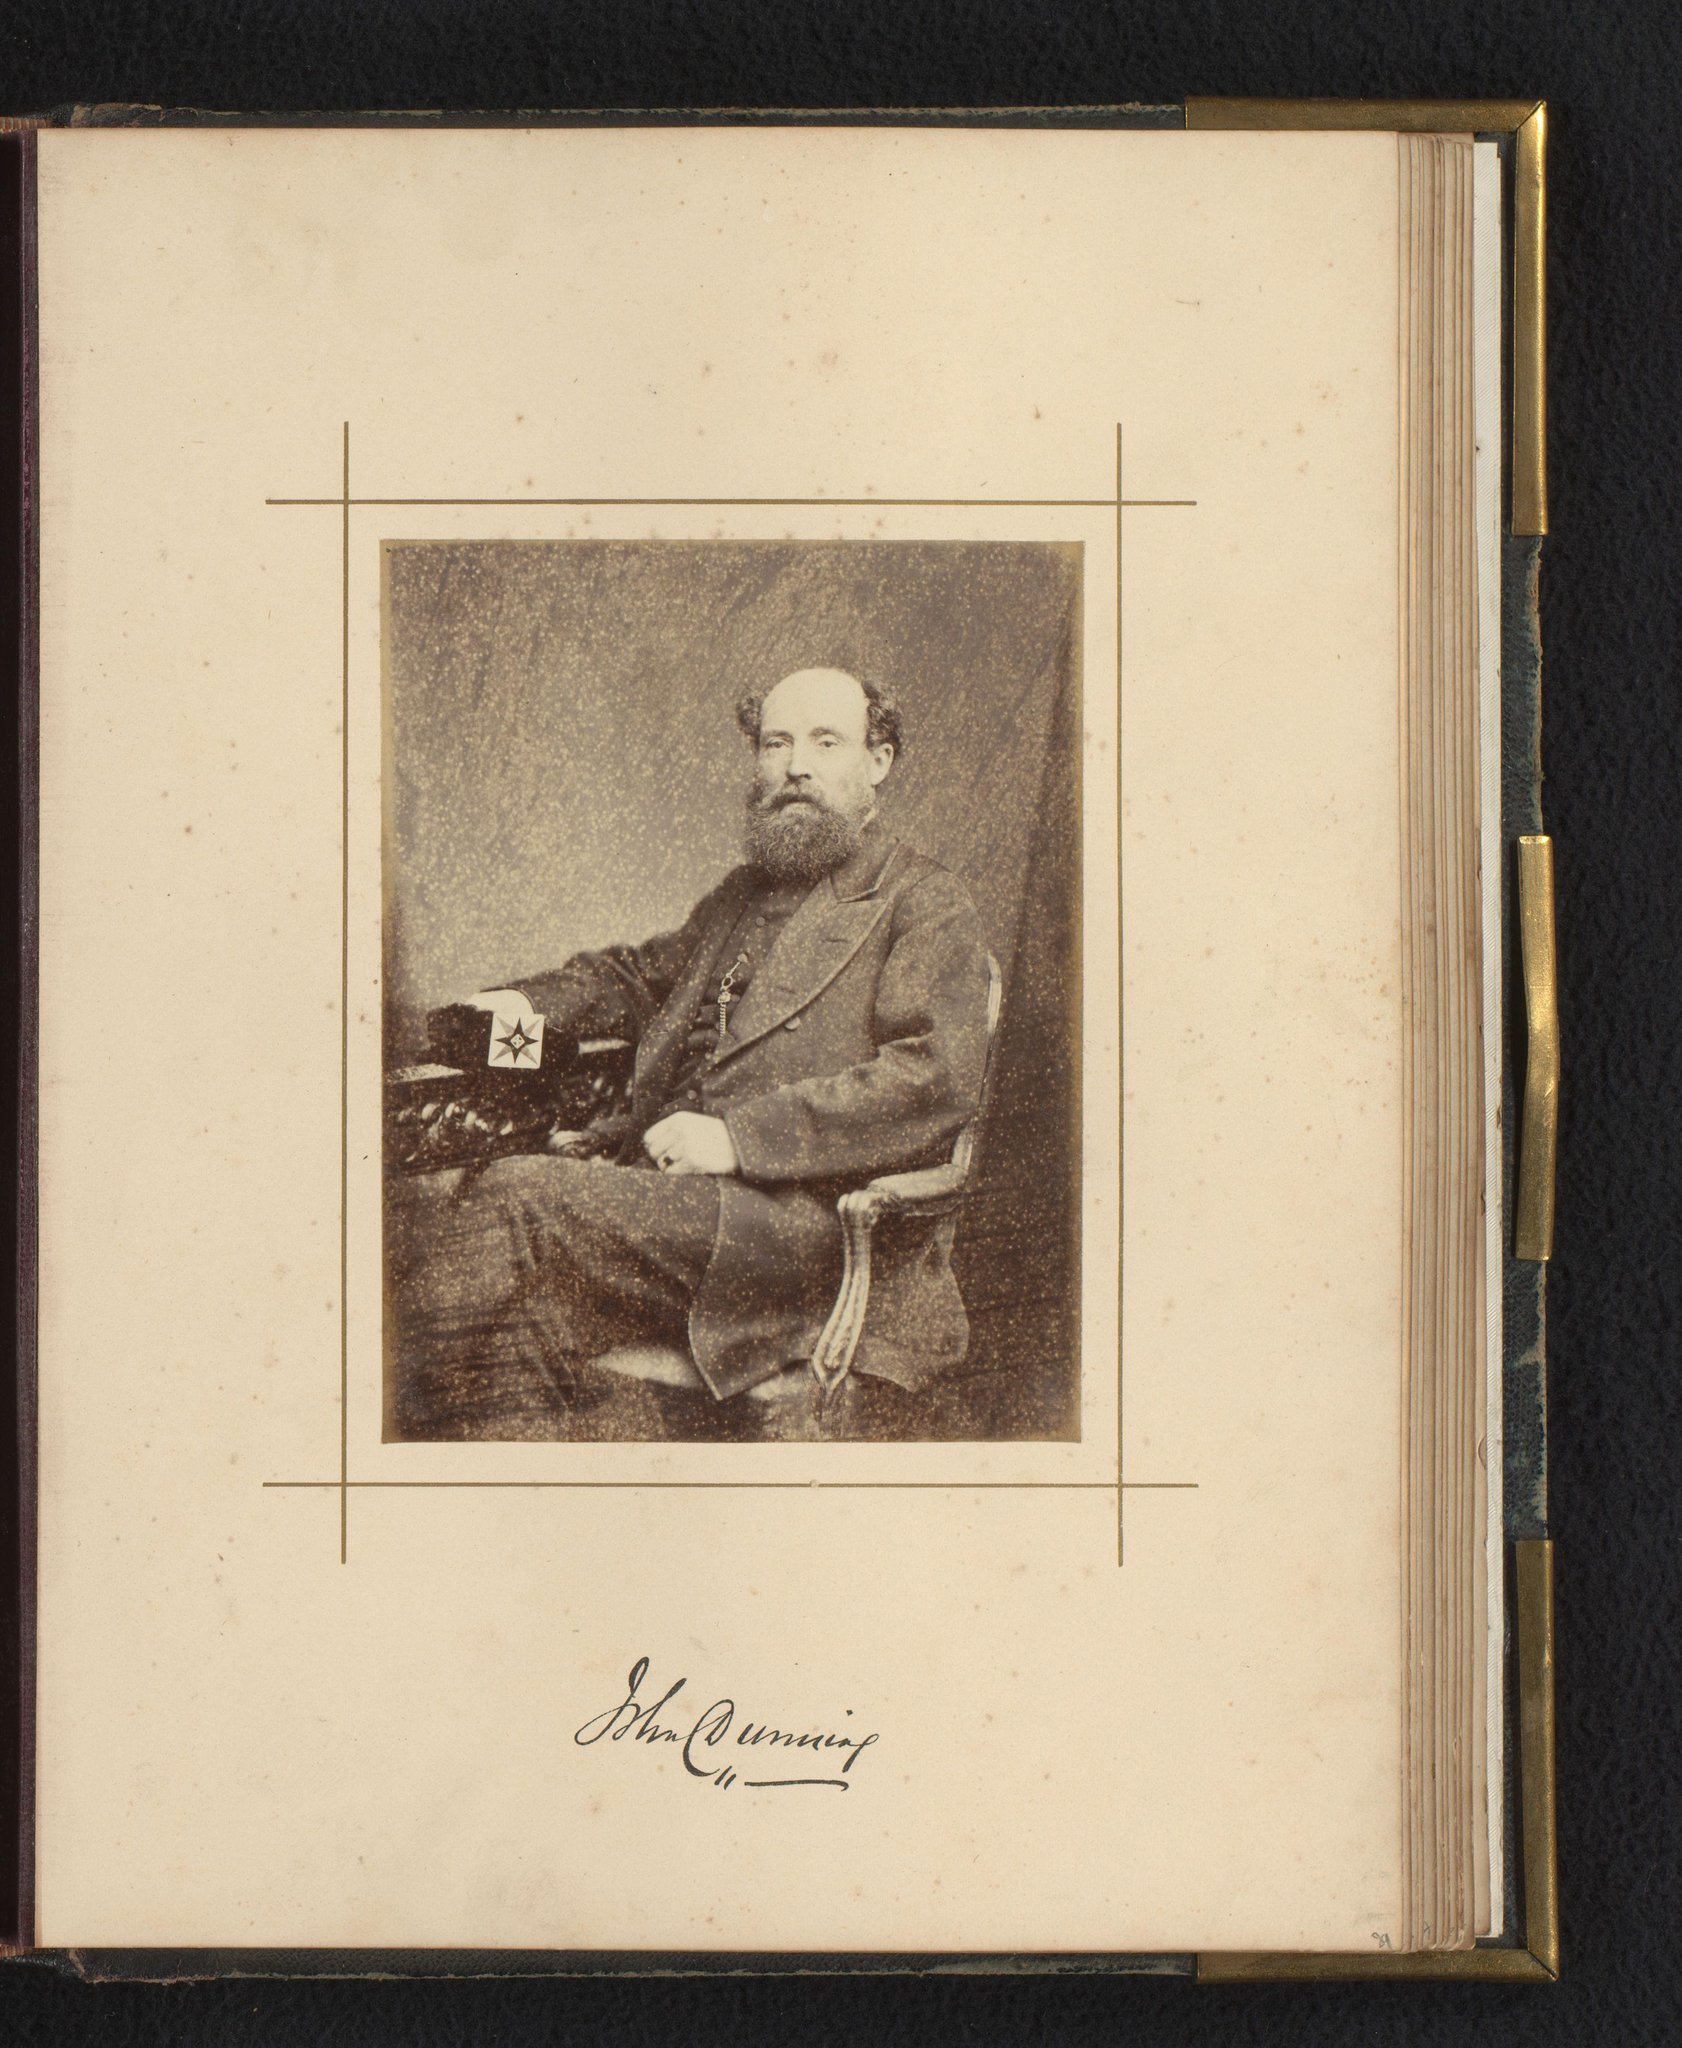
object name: photograph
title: Portret van John Cunning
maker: Anonymous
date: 1866-1871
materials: photographic support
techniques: albumen print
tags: sitting figure, historical persons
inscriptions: name: ‘John Cunning’